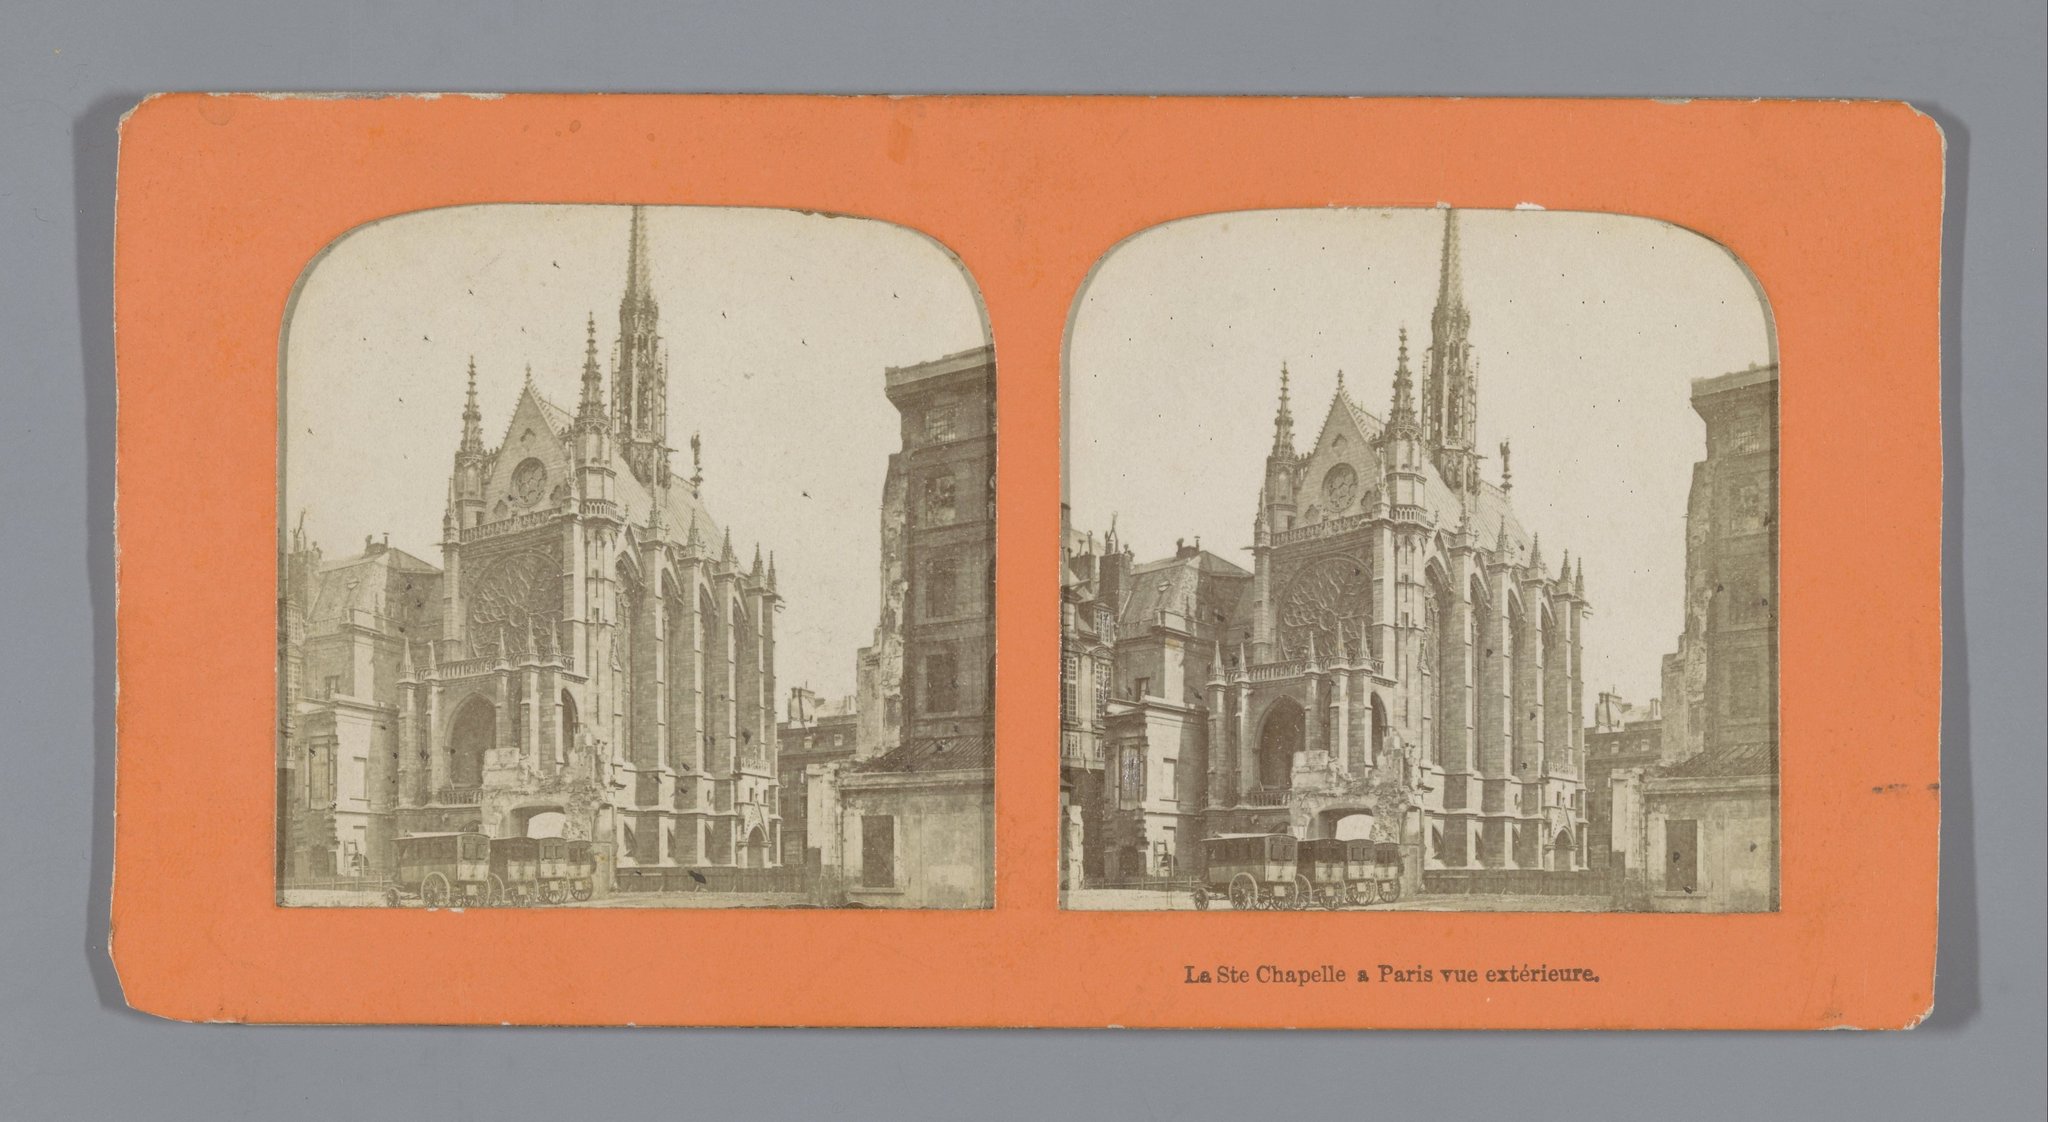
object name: tissue stereograph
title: Exterieur van de Sainte-Chapelle in Paris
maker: Anonymous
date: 1855-1875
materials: cardboard, paper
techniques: albumen print, cutting, hand coloring, perforating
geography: paris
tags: church (exterior)